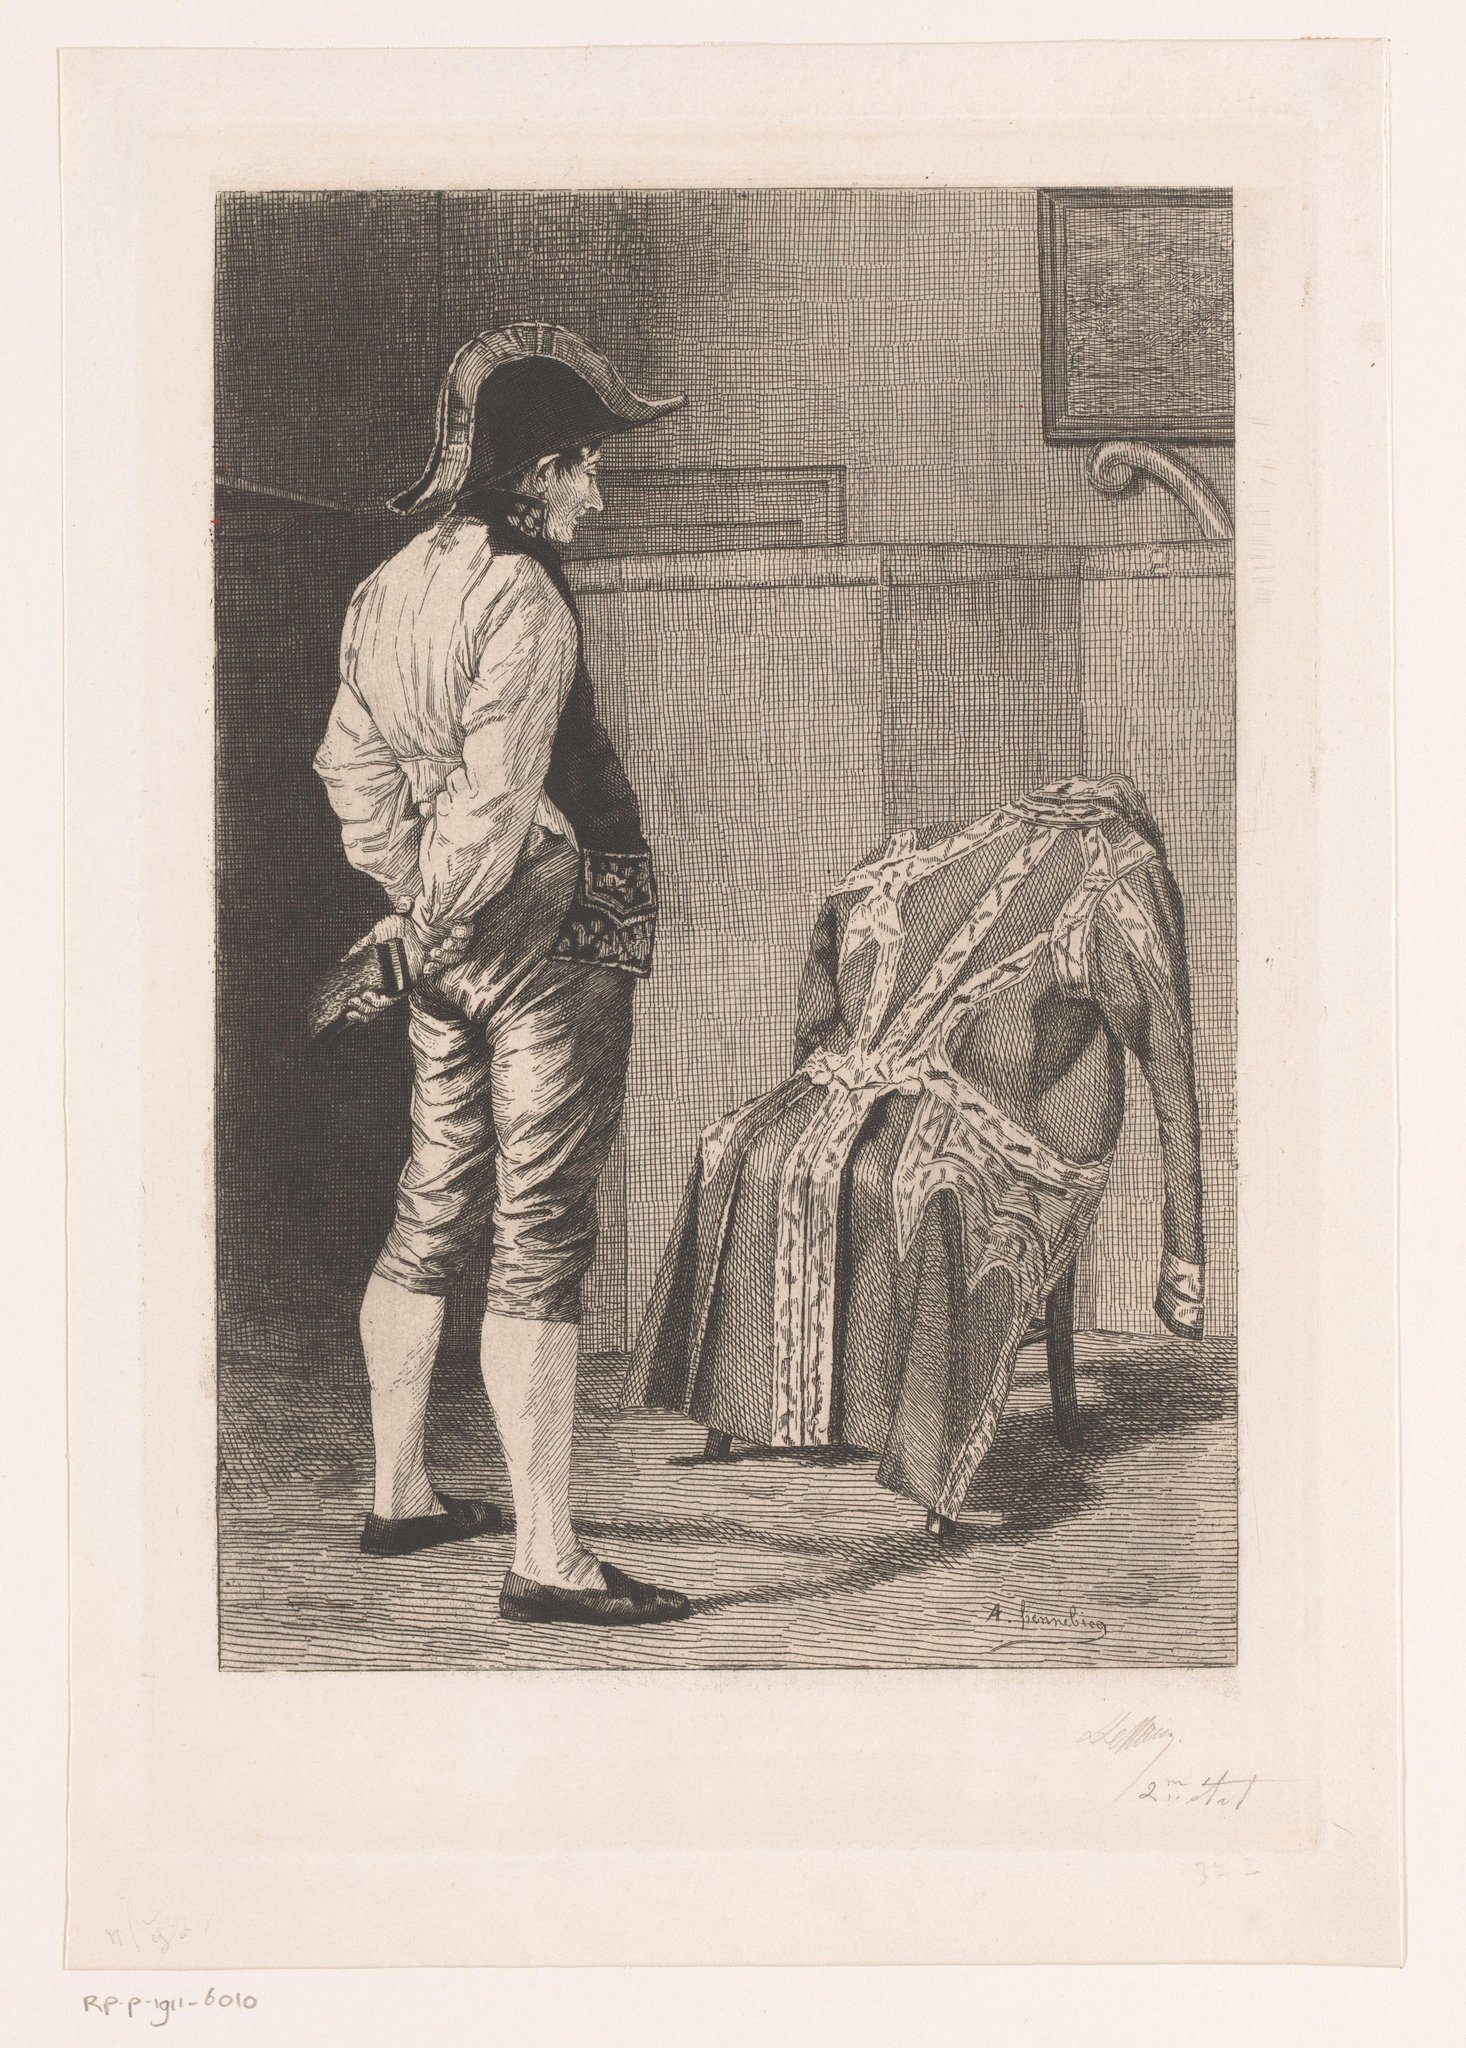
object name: print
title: Man met kledingborstel kijkt naar zijn jas die over een stoel hangt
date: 1861-1911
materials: paper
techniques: etching, intaglio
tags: care of clothes, e.g.: brushing, beating, airing, adult man, (military) uniforms, coat, cape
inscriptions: collector's mark: Lugt 2228, inscription: ‘LLeNain 2m état’